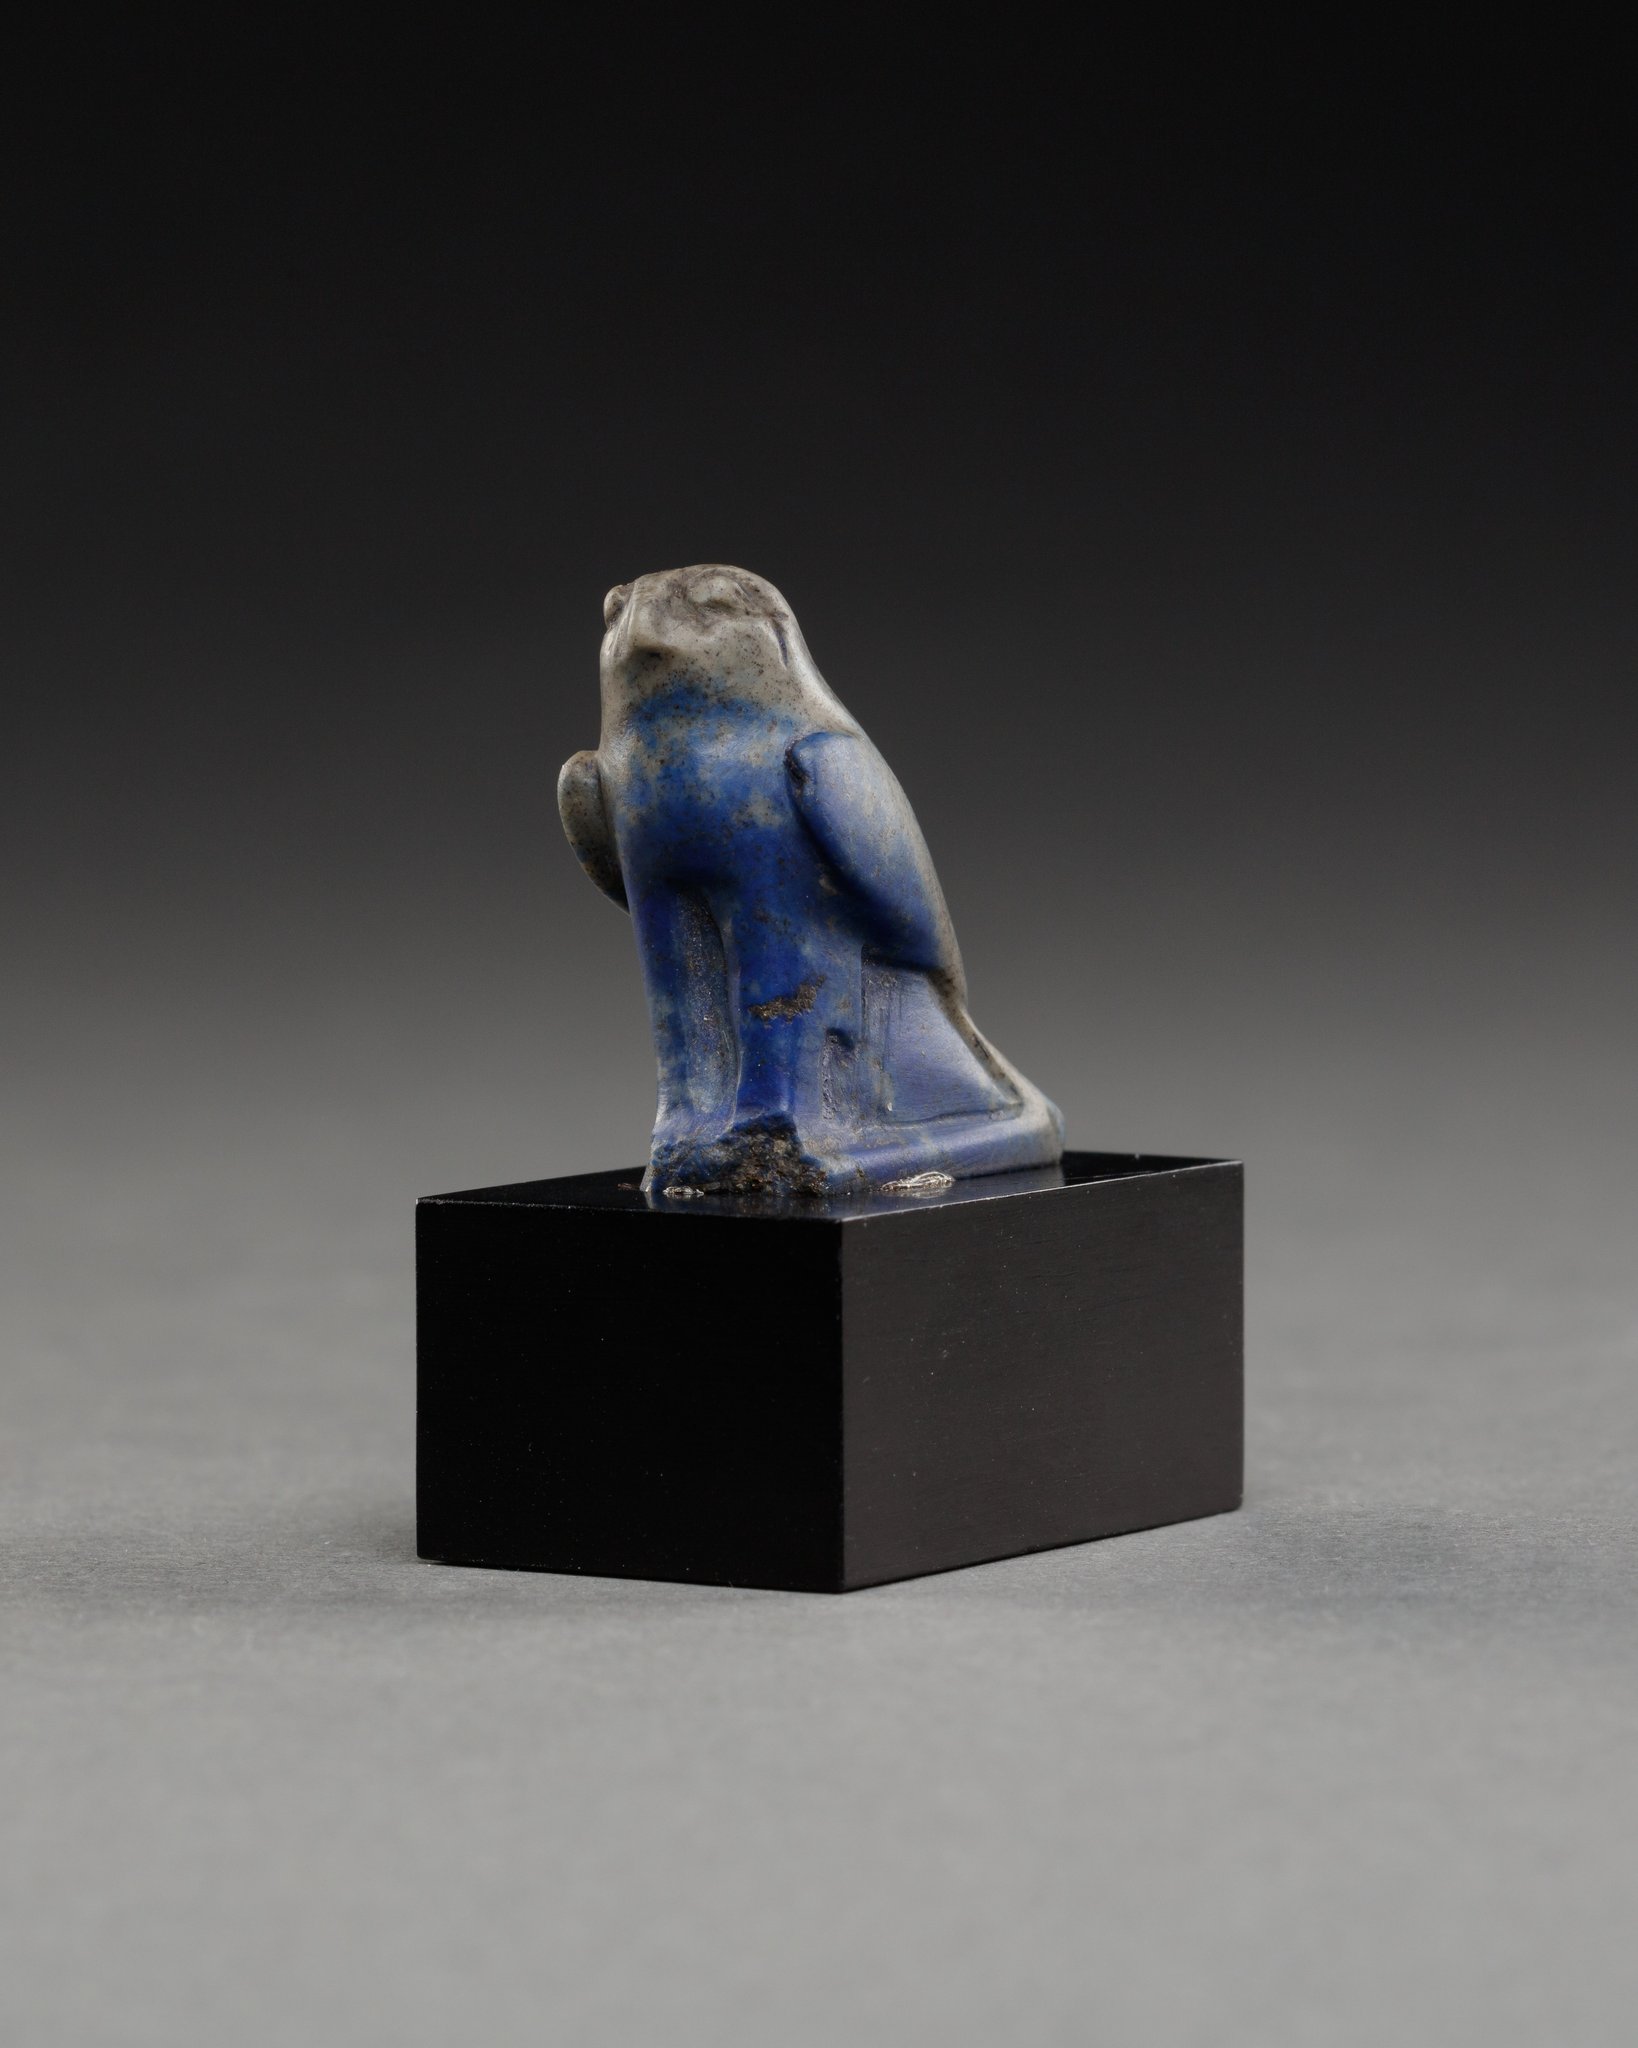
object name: amulet, falcon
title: Falcon Amulet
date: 664-630 BCE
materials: lapis lazuli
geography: egypt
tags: falcons